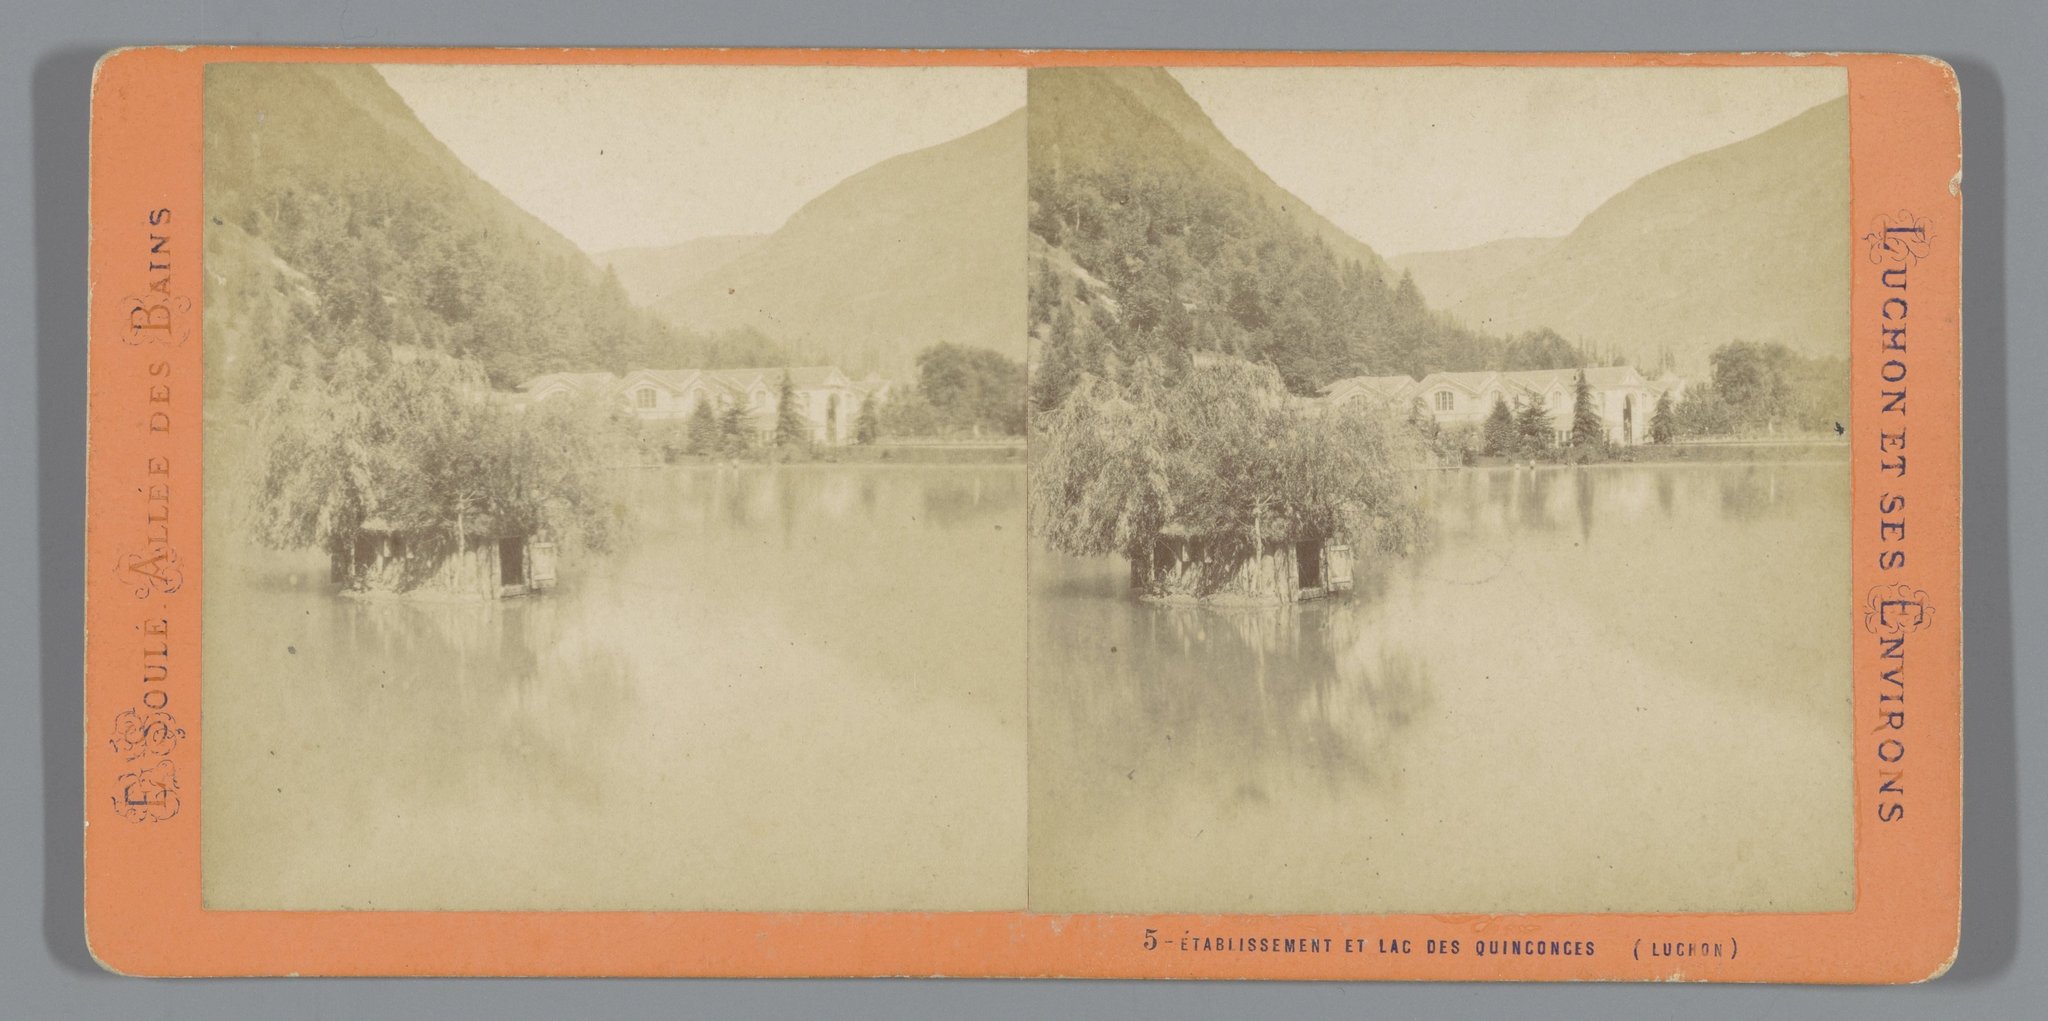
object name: stereograph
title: Établissement et Lac des Quinconces (Luchon)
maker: e. soule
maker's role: fotograaf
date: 1860-1880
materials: cardboard, photographic support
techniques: albumen print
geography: pyrenees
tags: lake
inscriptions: number: ‘5’